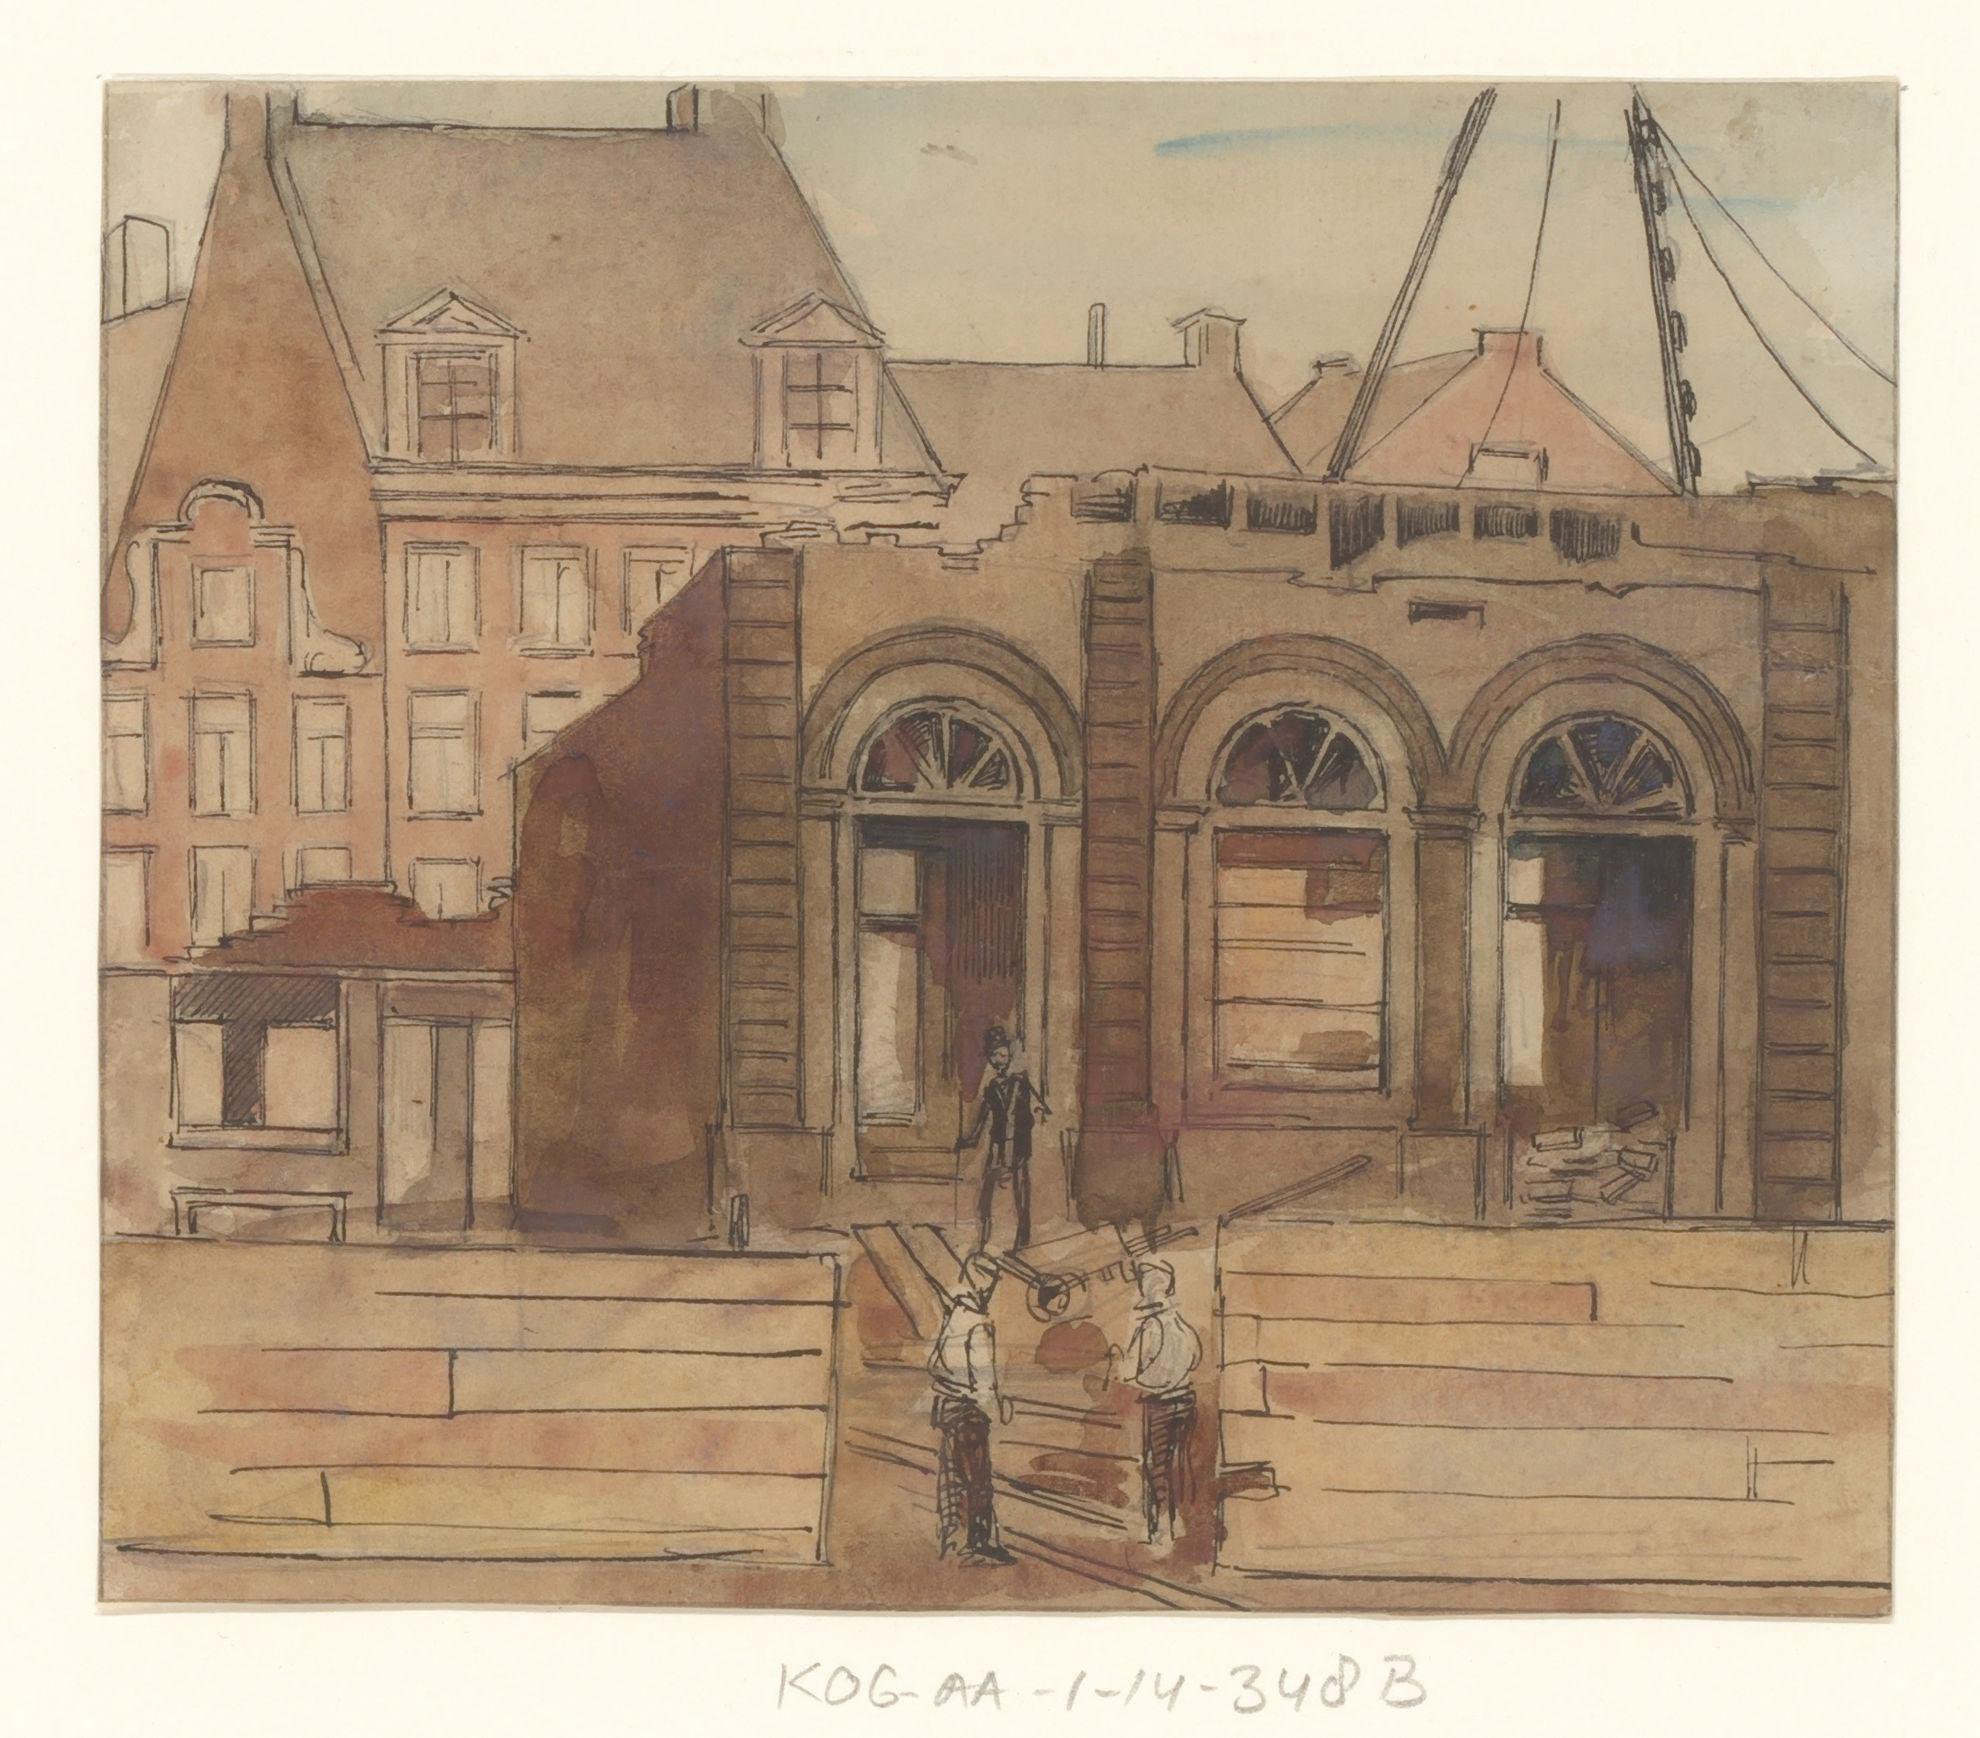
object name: drawing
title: Gezicht op een bouwterrein aan de Nieuwezijds Voorburgwal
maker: willem steelink (ii)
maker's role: draughtsman, print maker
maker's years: 1856-1928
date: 1866-1928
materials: ink, paper, pencil, watercolor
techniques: brush, pen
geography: amsterdam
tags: city-view in general; 'veduta', building-site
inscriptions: collector's mark: ‘14’ Lugt 1641b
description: Onderwerpsrubriek binnen de Atlas Amsterdam: Verhulststraat (Johannes), Viaducten, Vierwindenstraat, Vinkenbuurt, Vinkenpad, Vinkenstraat, Vischsteeg, Vliegendesteeg, Voetboogstraat, Volewijk, Vondelstraat, Voorburgwal (N.Z.).